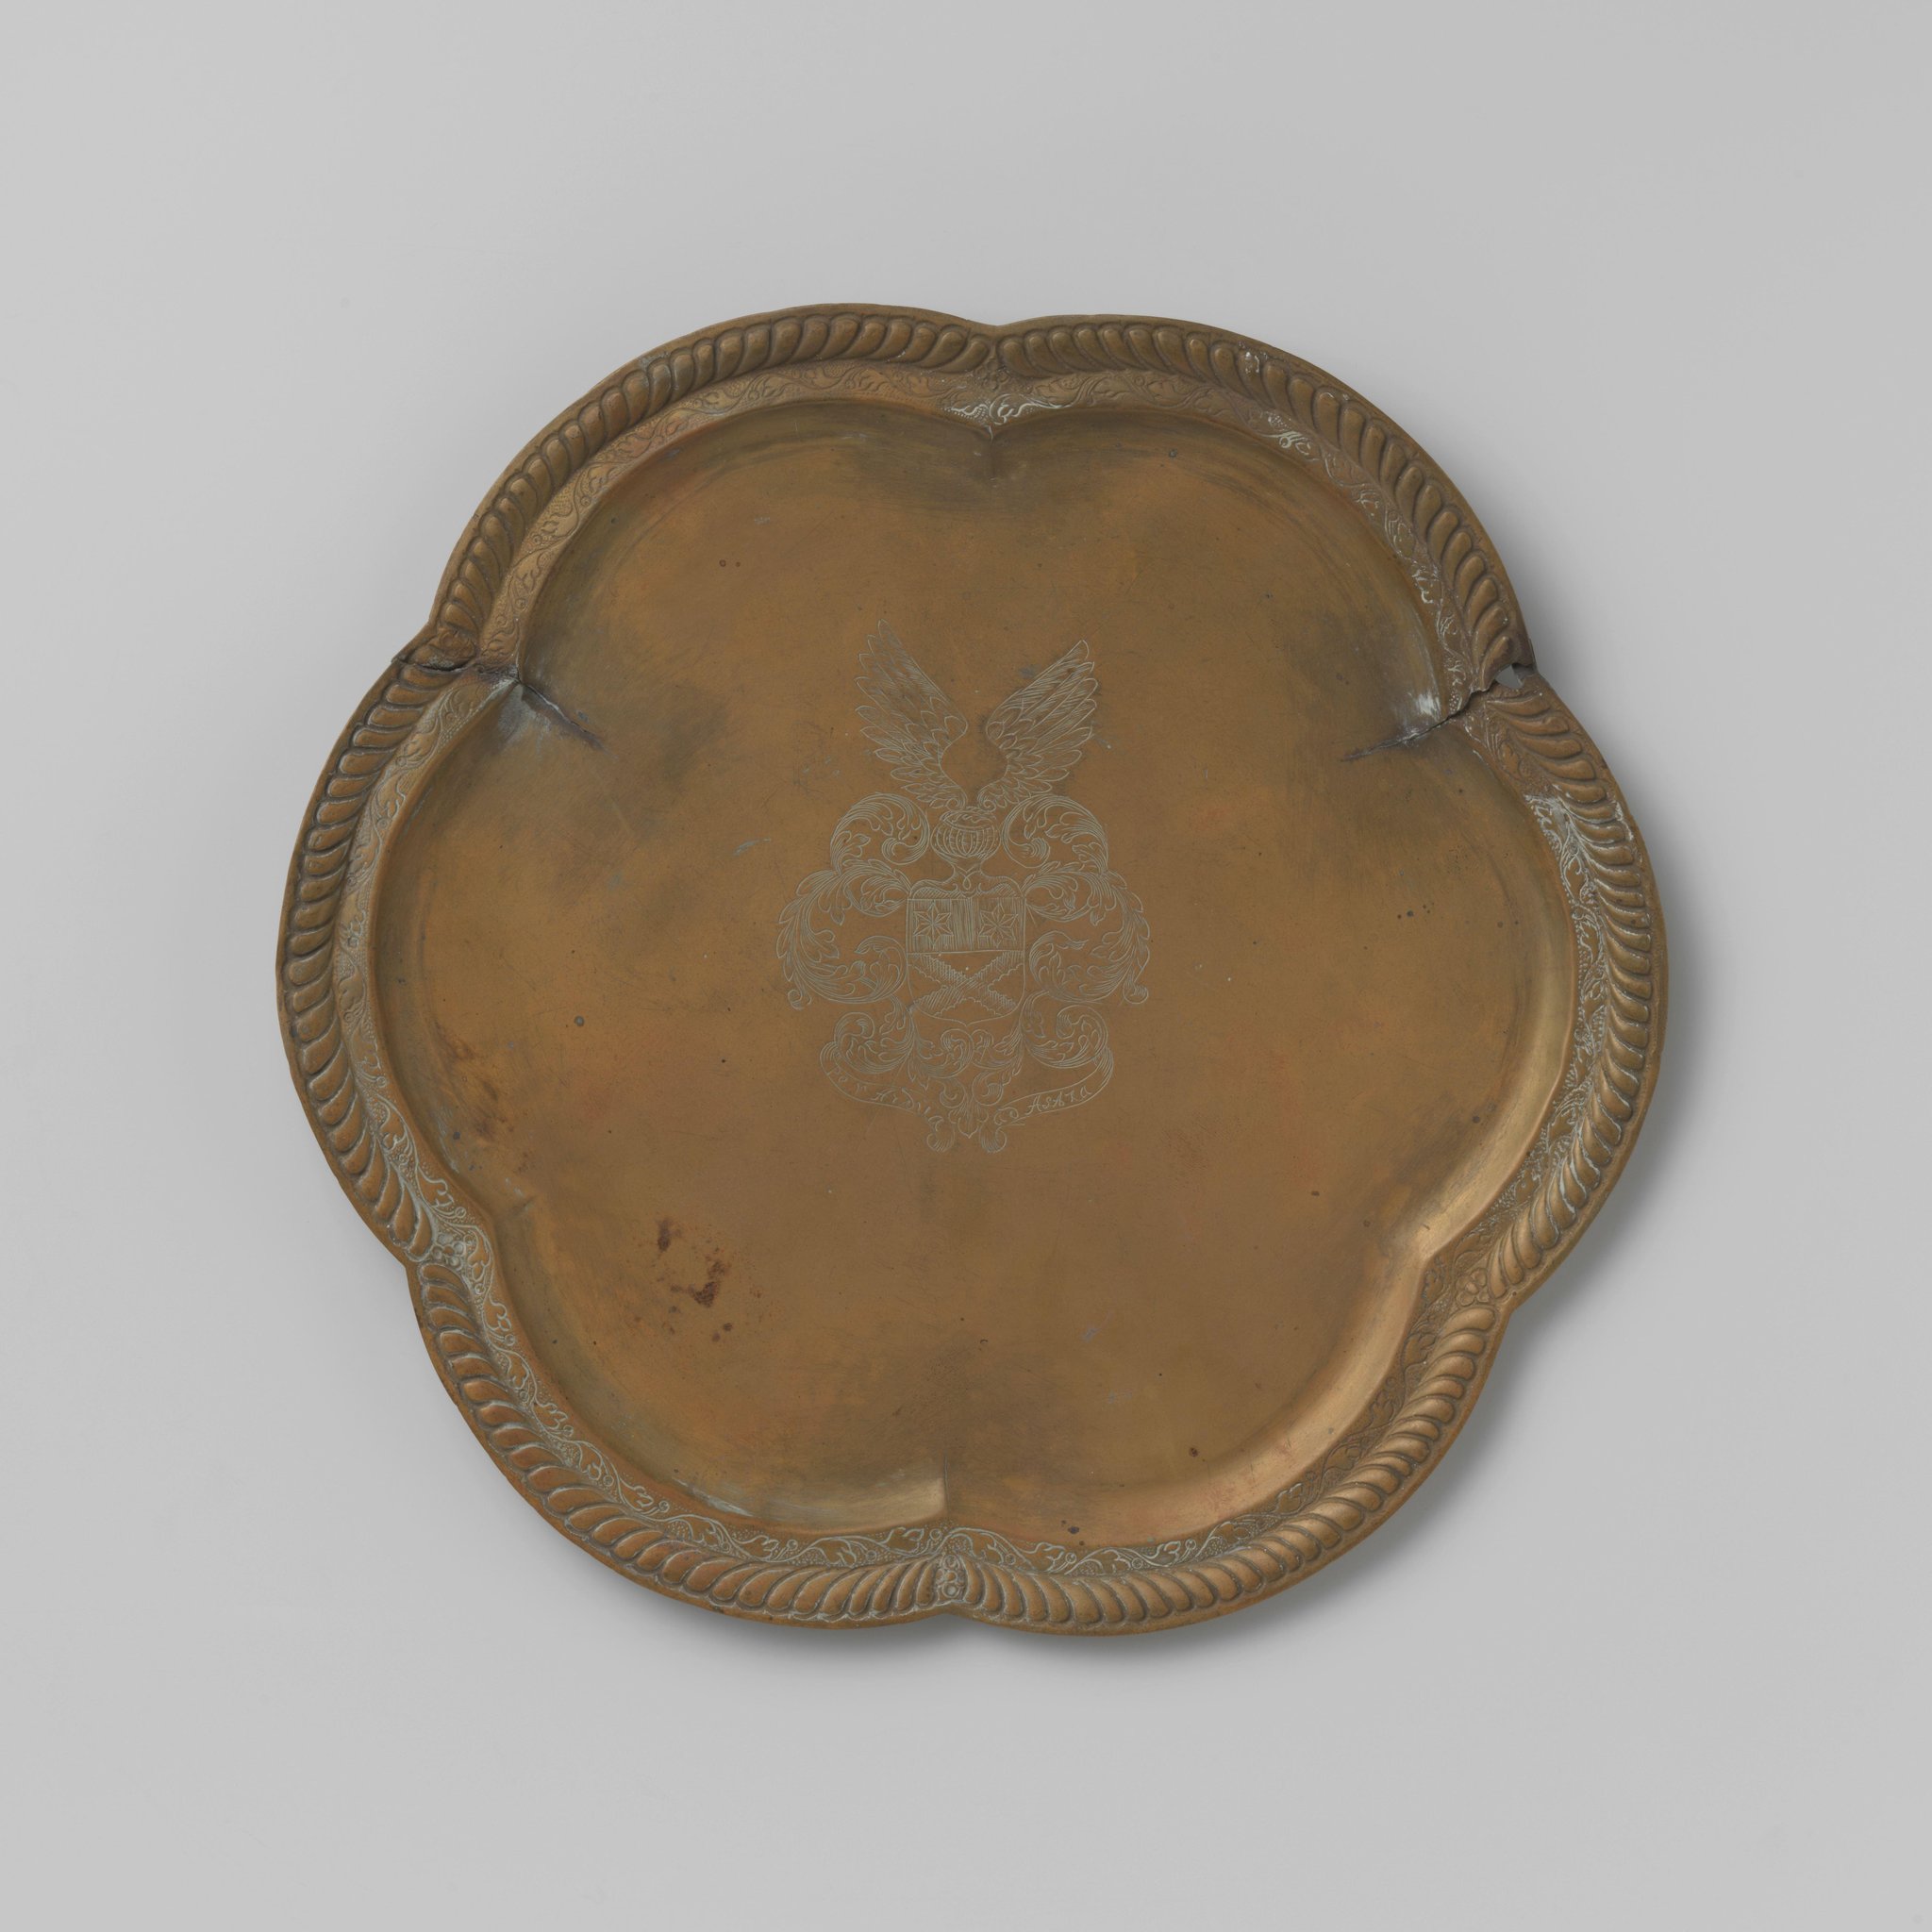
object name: dish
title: Schaal met wapenschild en devies 'per Ardua ad Astra'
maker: Anonymous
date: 1725-1750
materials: brass, metal alloy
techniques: casting, engraving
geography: batavia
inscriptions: inscription: ‘per Ardua ad Astra’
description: De schaal heeft de vorm van een zespas met een even opstaande rand. Deze is versierd met gegraveerd rankwerk op gegranuleerde achtergrond, langs gedreven naar elkaar toegewende godronlijsten, welke worden onderbroken door zes rozetten. Op de bodem een gegraveerd door bladornament omgeven wapenschild met in de bovenste helft twee zespuntige sterren en in de onderste helft een schuinkruis. Boven het wapenschild een helm met twee vleugels, onder het wapenschild twee banderollen met het devies 'per Ardua ad Astra'.